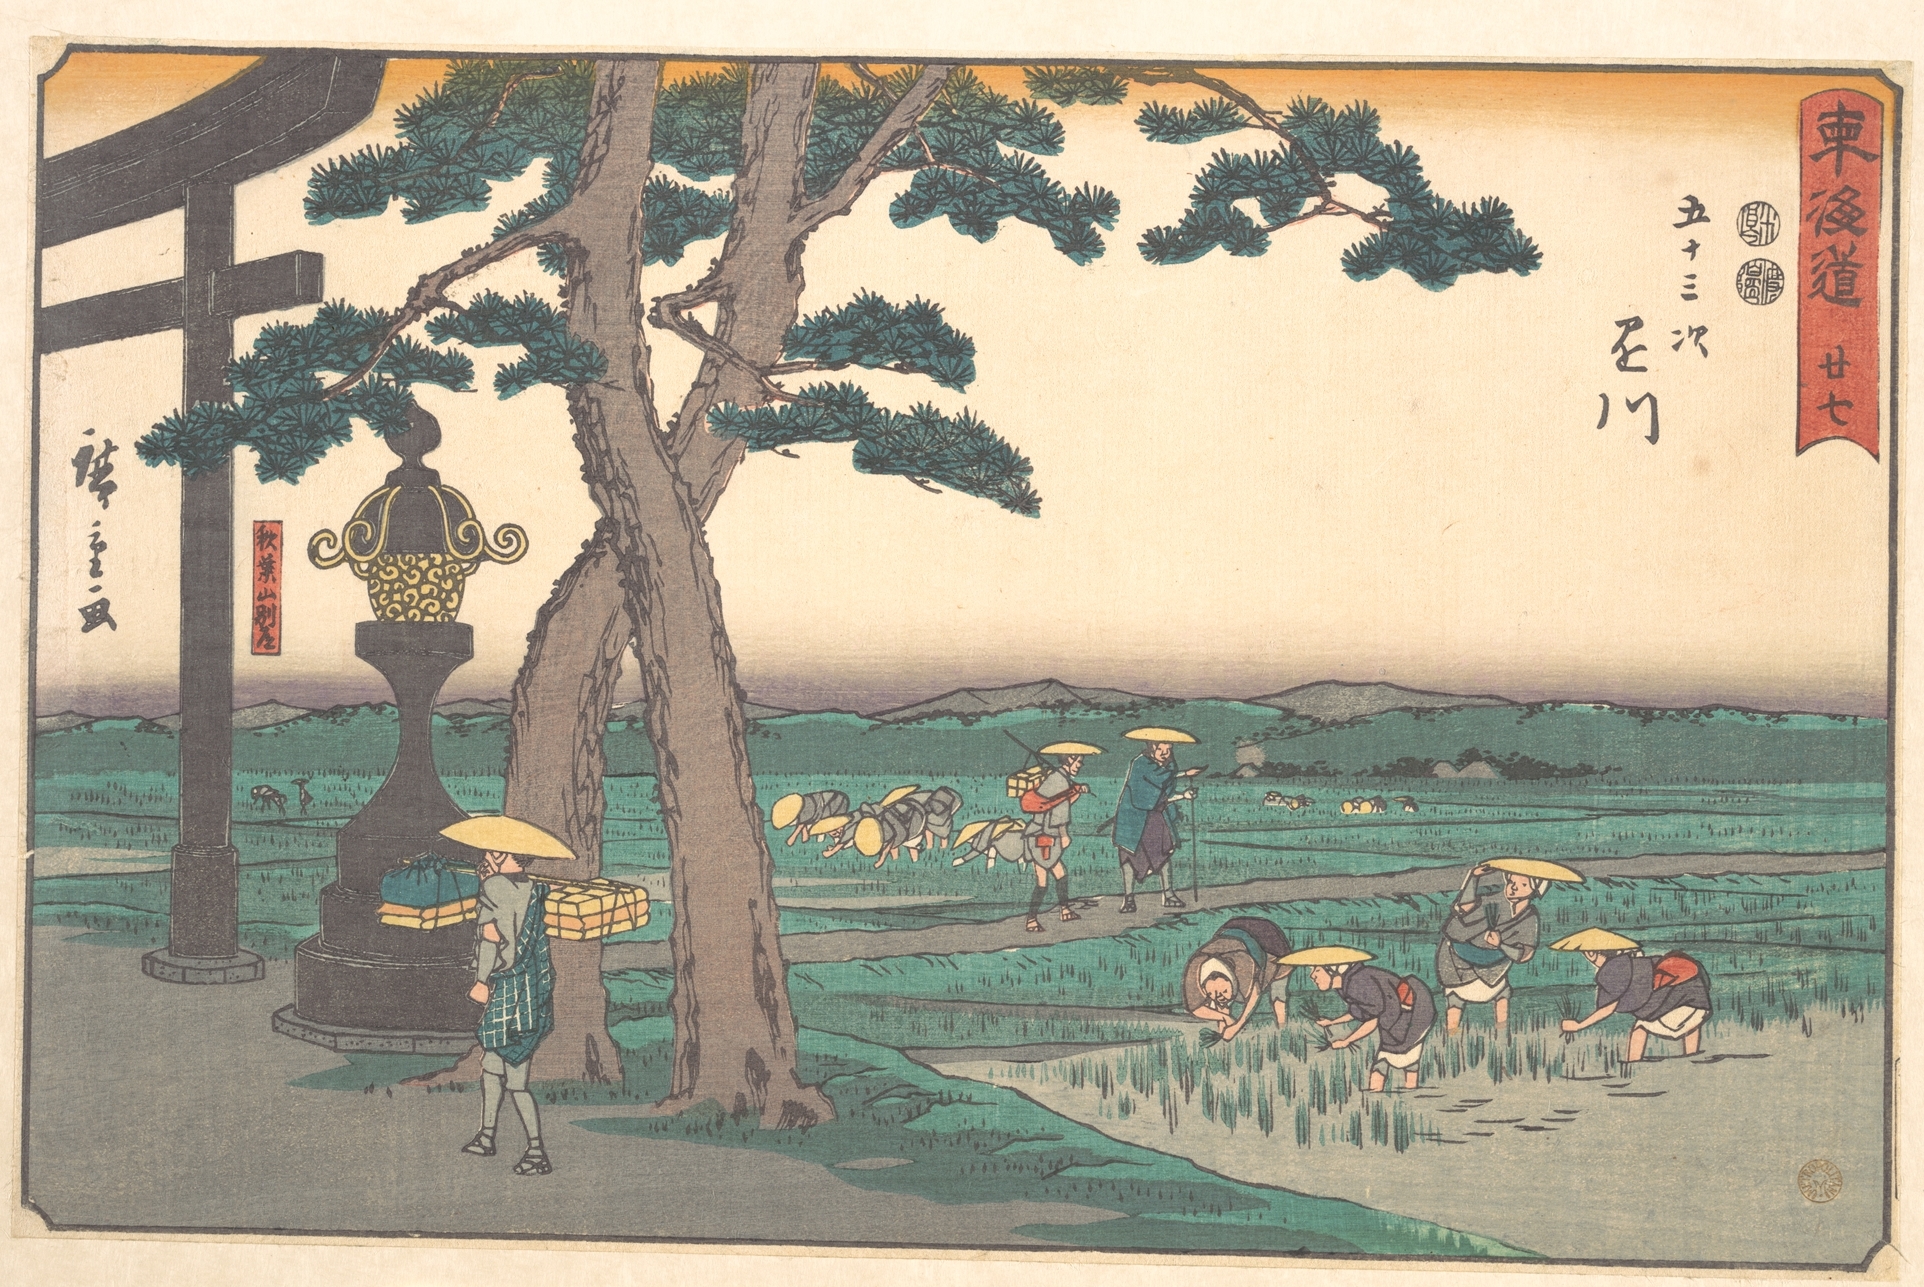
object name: print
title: Kakegawa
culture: japanese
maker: utagawa hiroshige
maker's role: artist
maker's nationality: japanese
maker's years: 1797-1858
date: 1840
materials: ink, paper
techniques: woodblock print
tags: farms,landscapes,trees,farmers